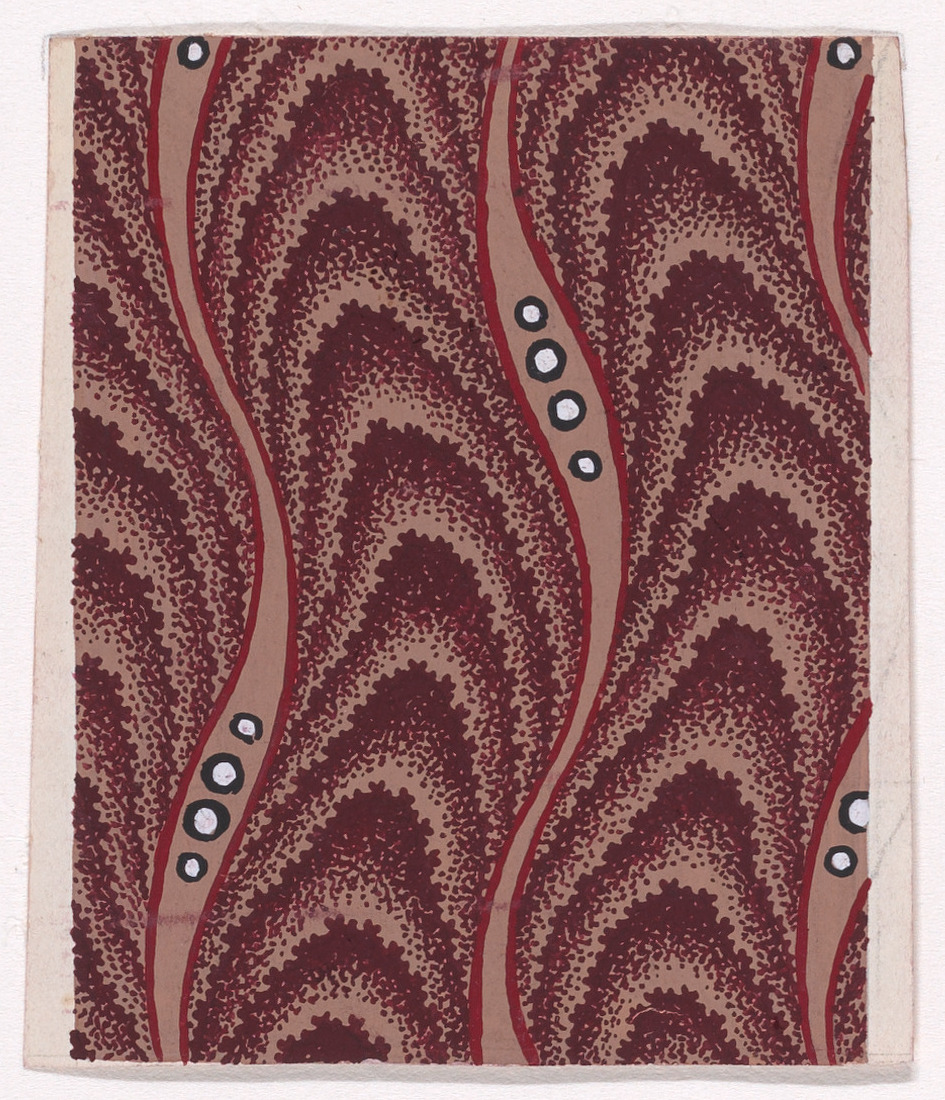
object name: drawing ornament architecture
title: Textile Design with Undulating Vertical Strips of Overlapping Scales Separated by Undulating Ribbons and Pearls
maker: anonymous, alsatian, 19th century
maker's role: artist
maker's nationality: alsatian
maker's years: 1800-1900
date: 1840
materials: gouache